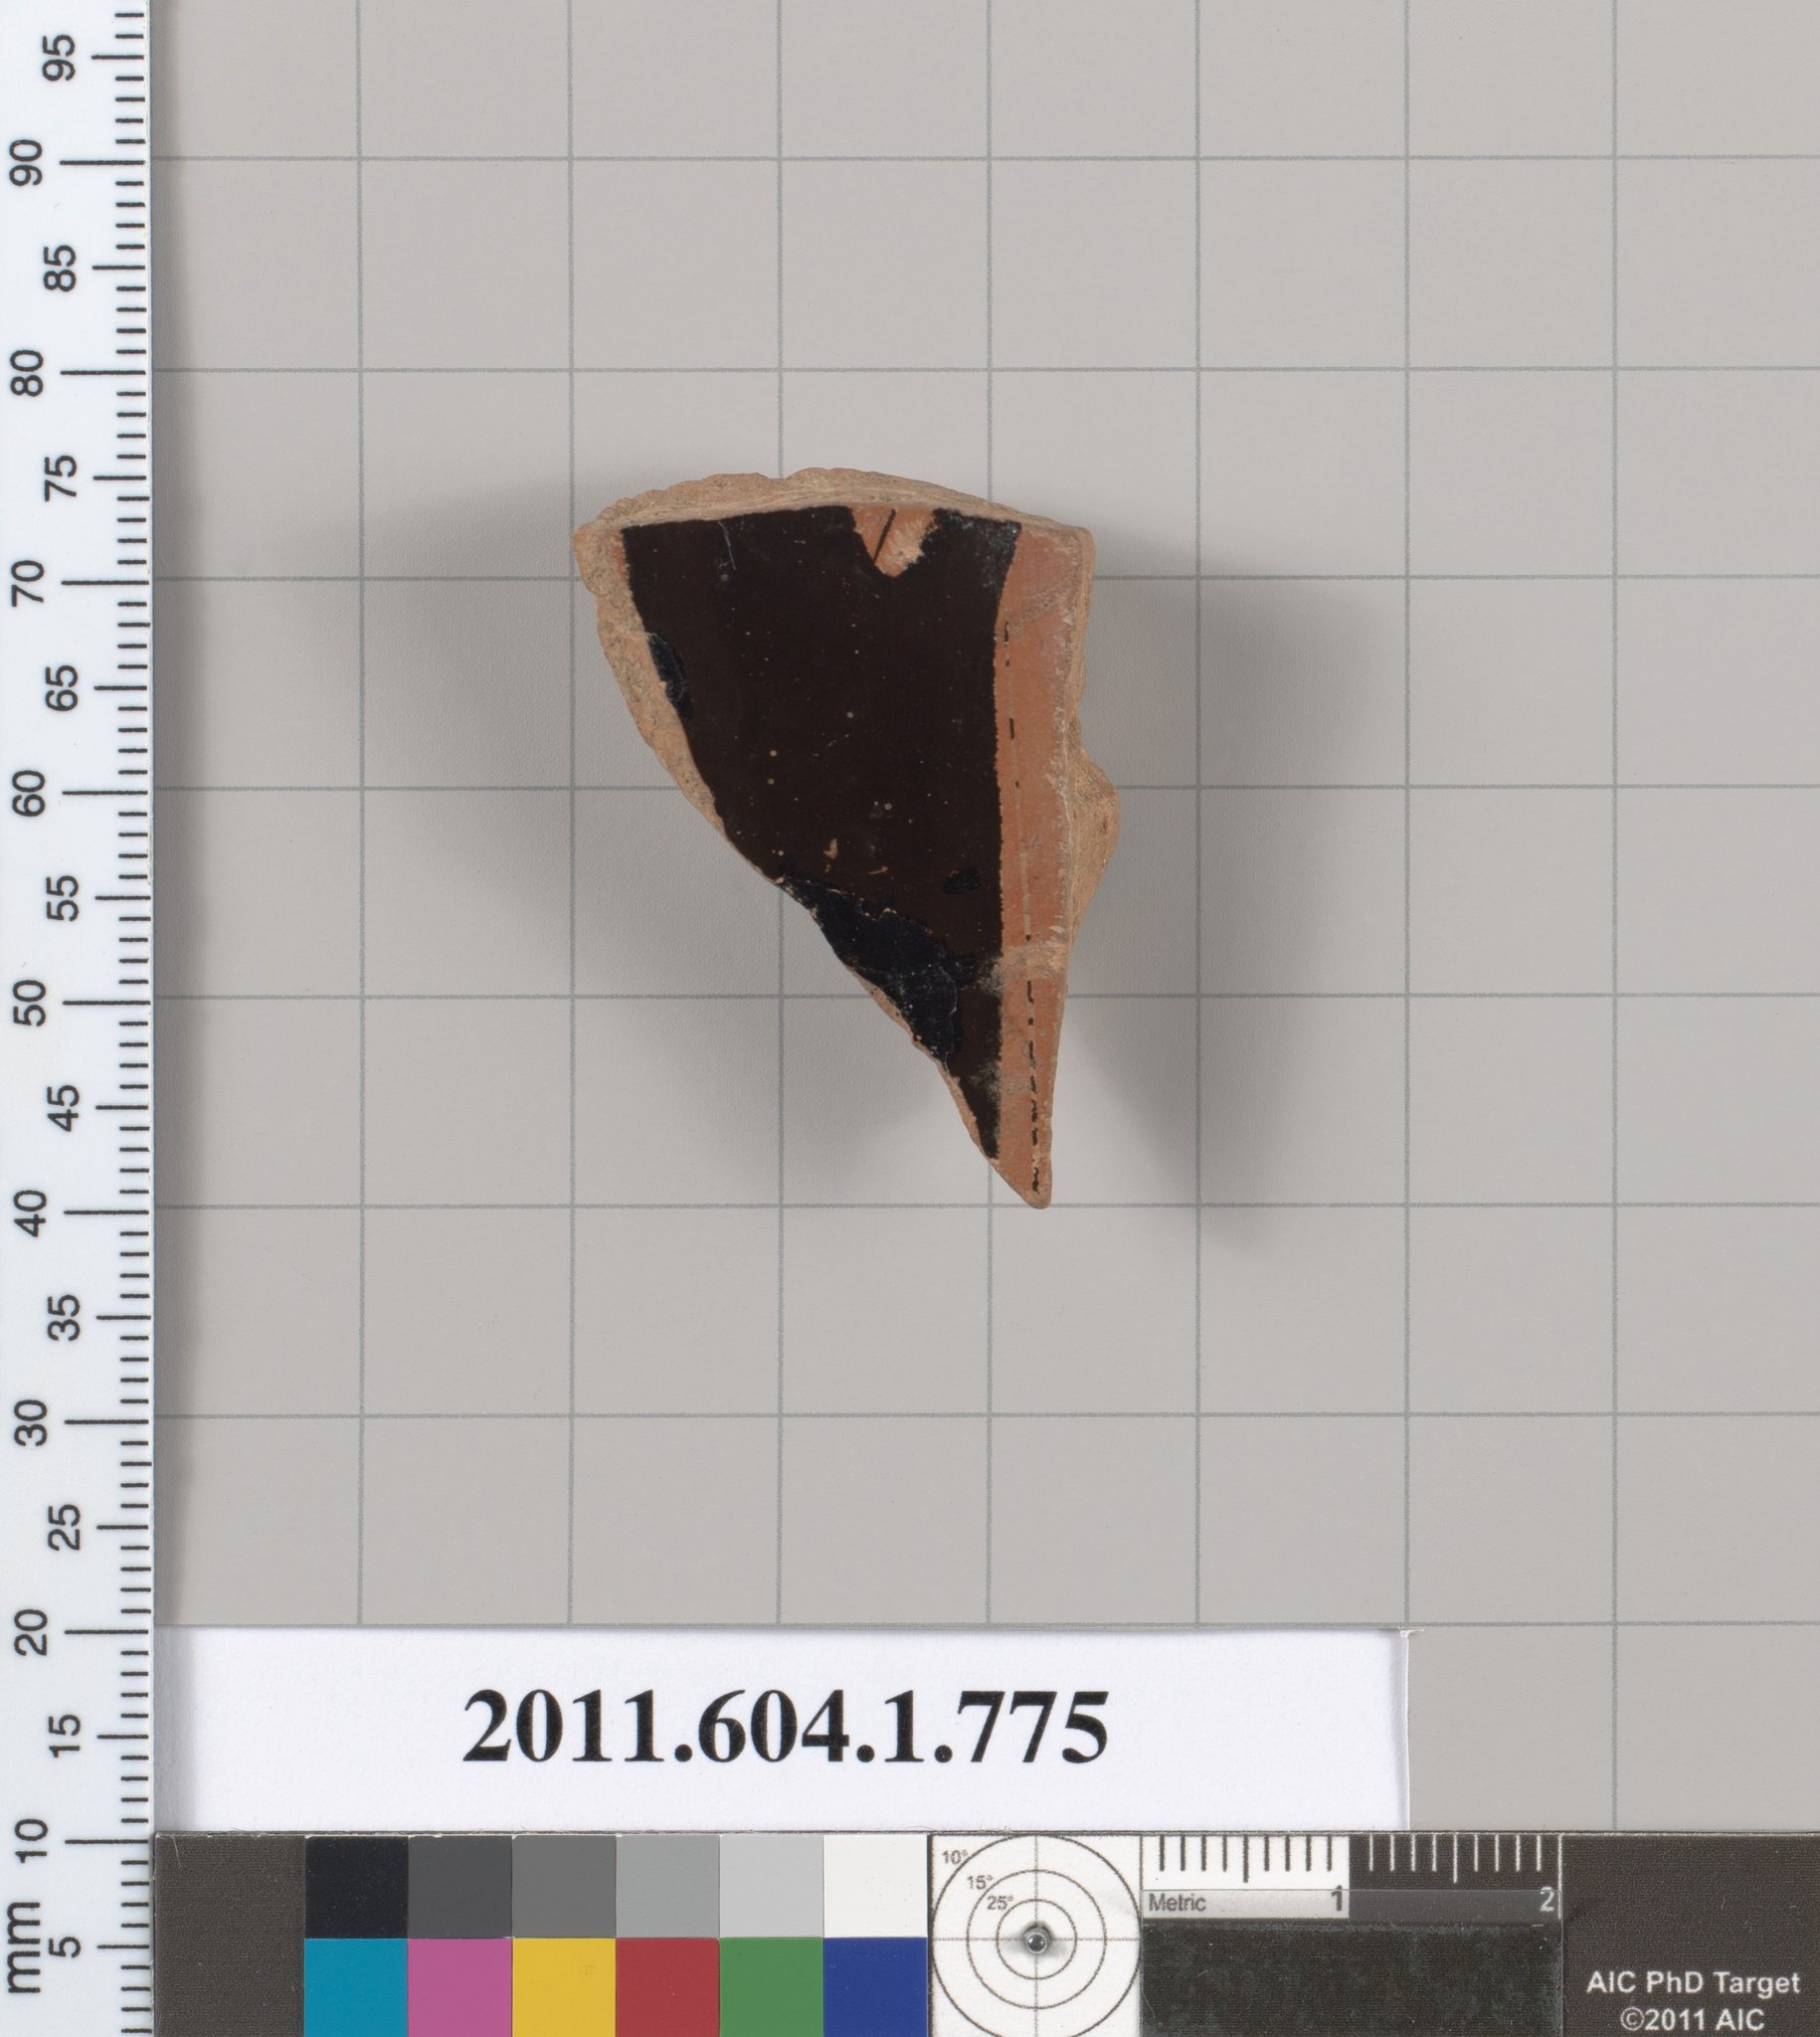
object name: kylix fragment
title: Terracotta fragment of a kylix (drinking cup)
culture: greek, attic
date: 475-451 BCE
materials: terracotta